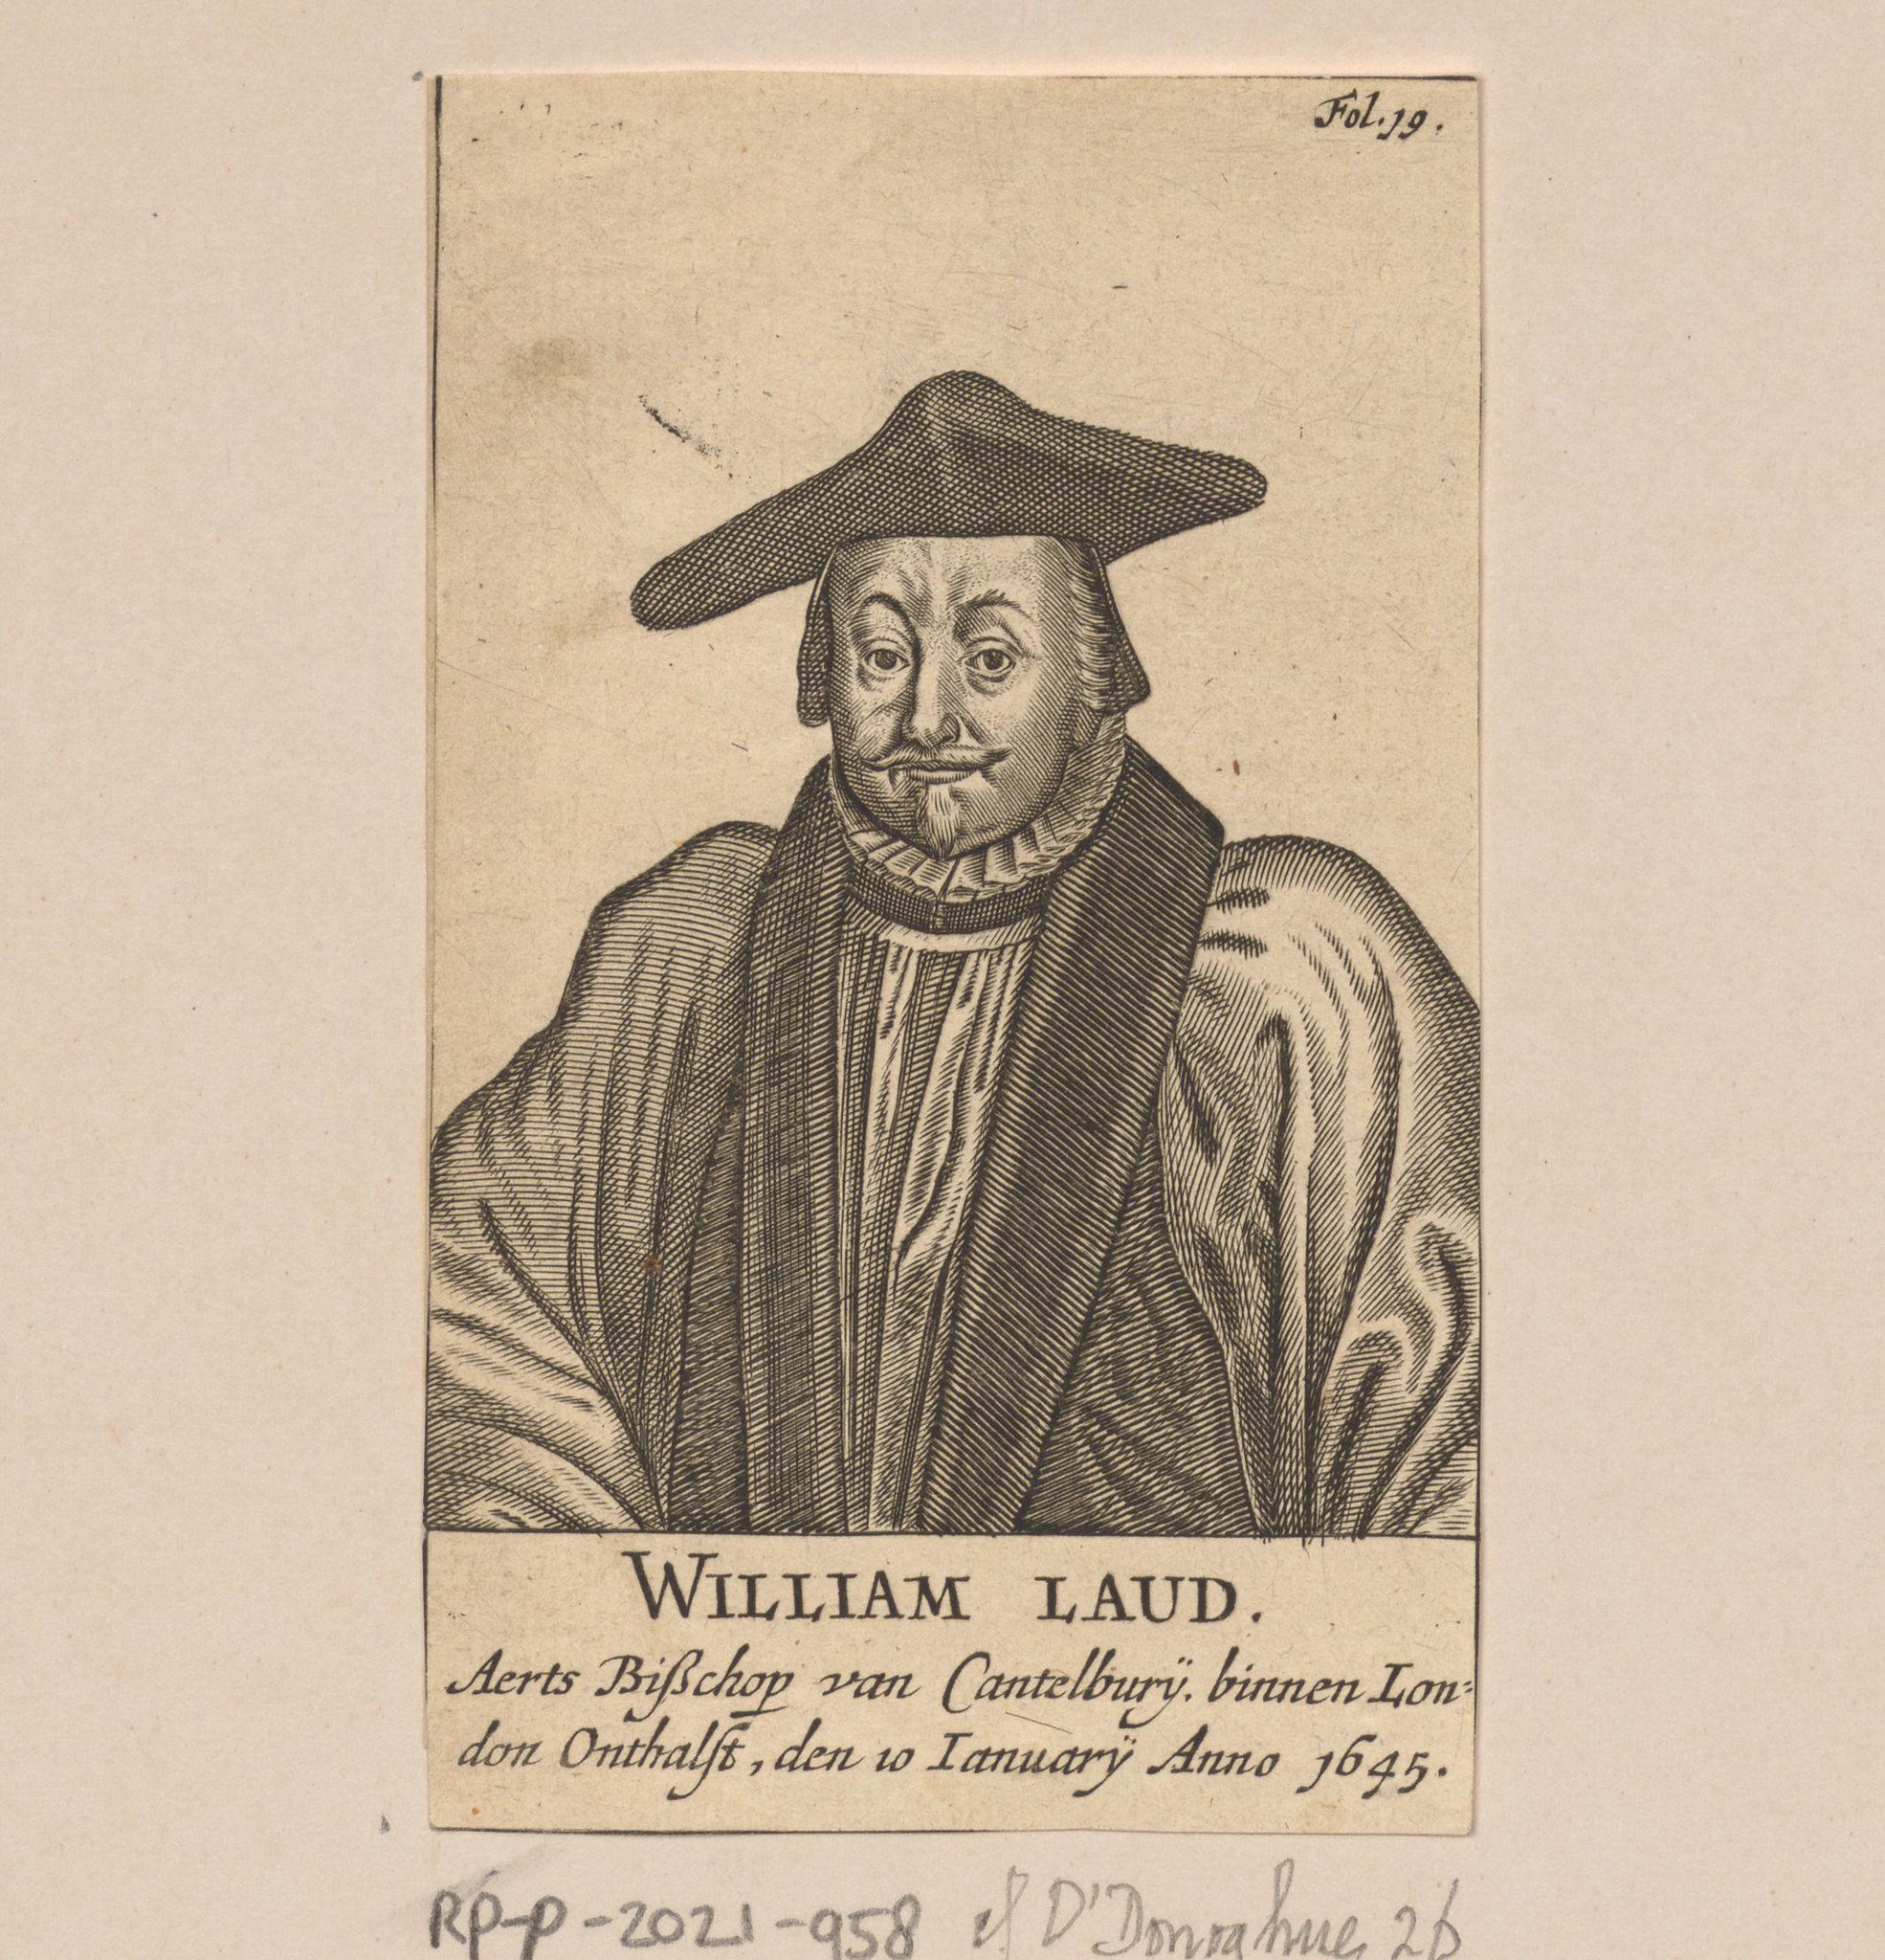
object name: book illustration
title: Portret van William Laud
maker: Anonymous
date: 1700-1799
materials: paper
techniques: engraving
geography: netherlands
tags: clergyman, archbishop, bishop, etc. (roman catholic), historical persons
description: Met onderschrift in het Nederlands. Rechtsboven: Fol. 19.